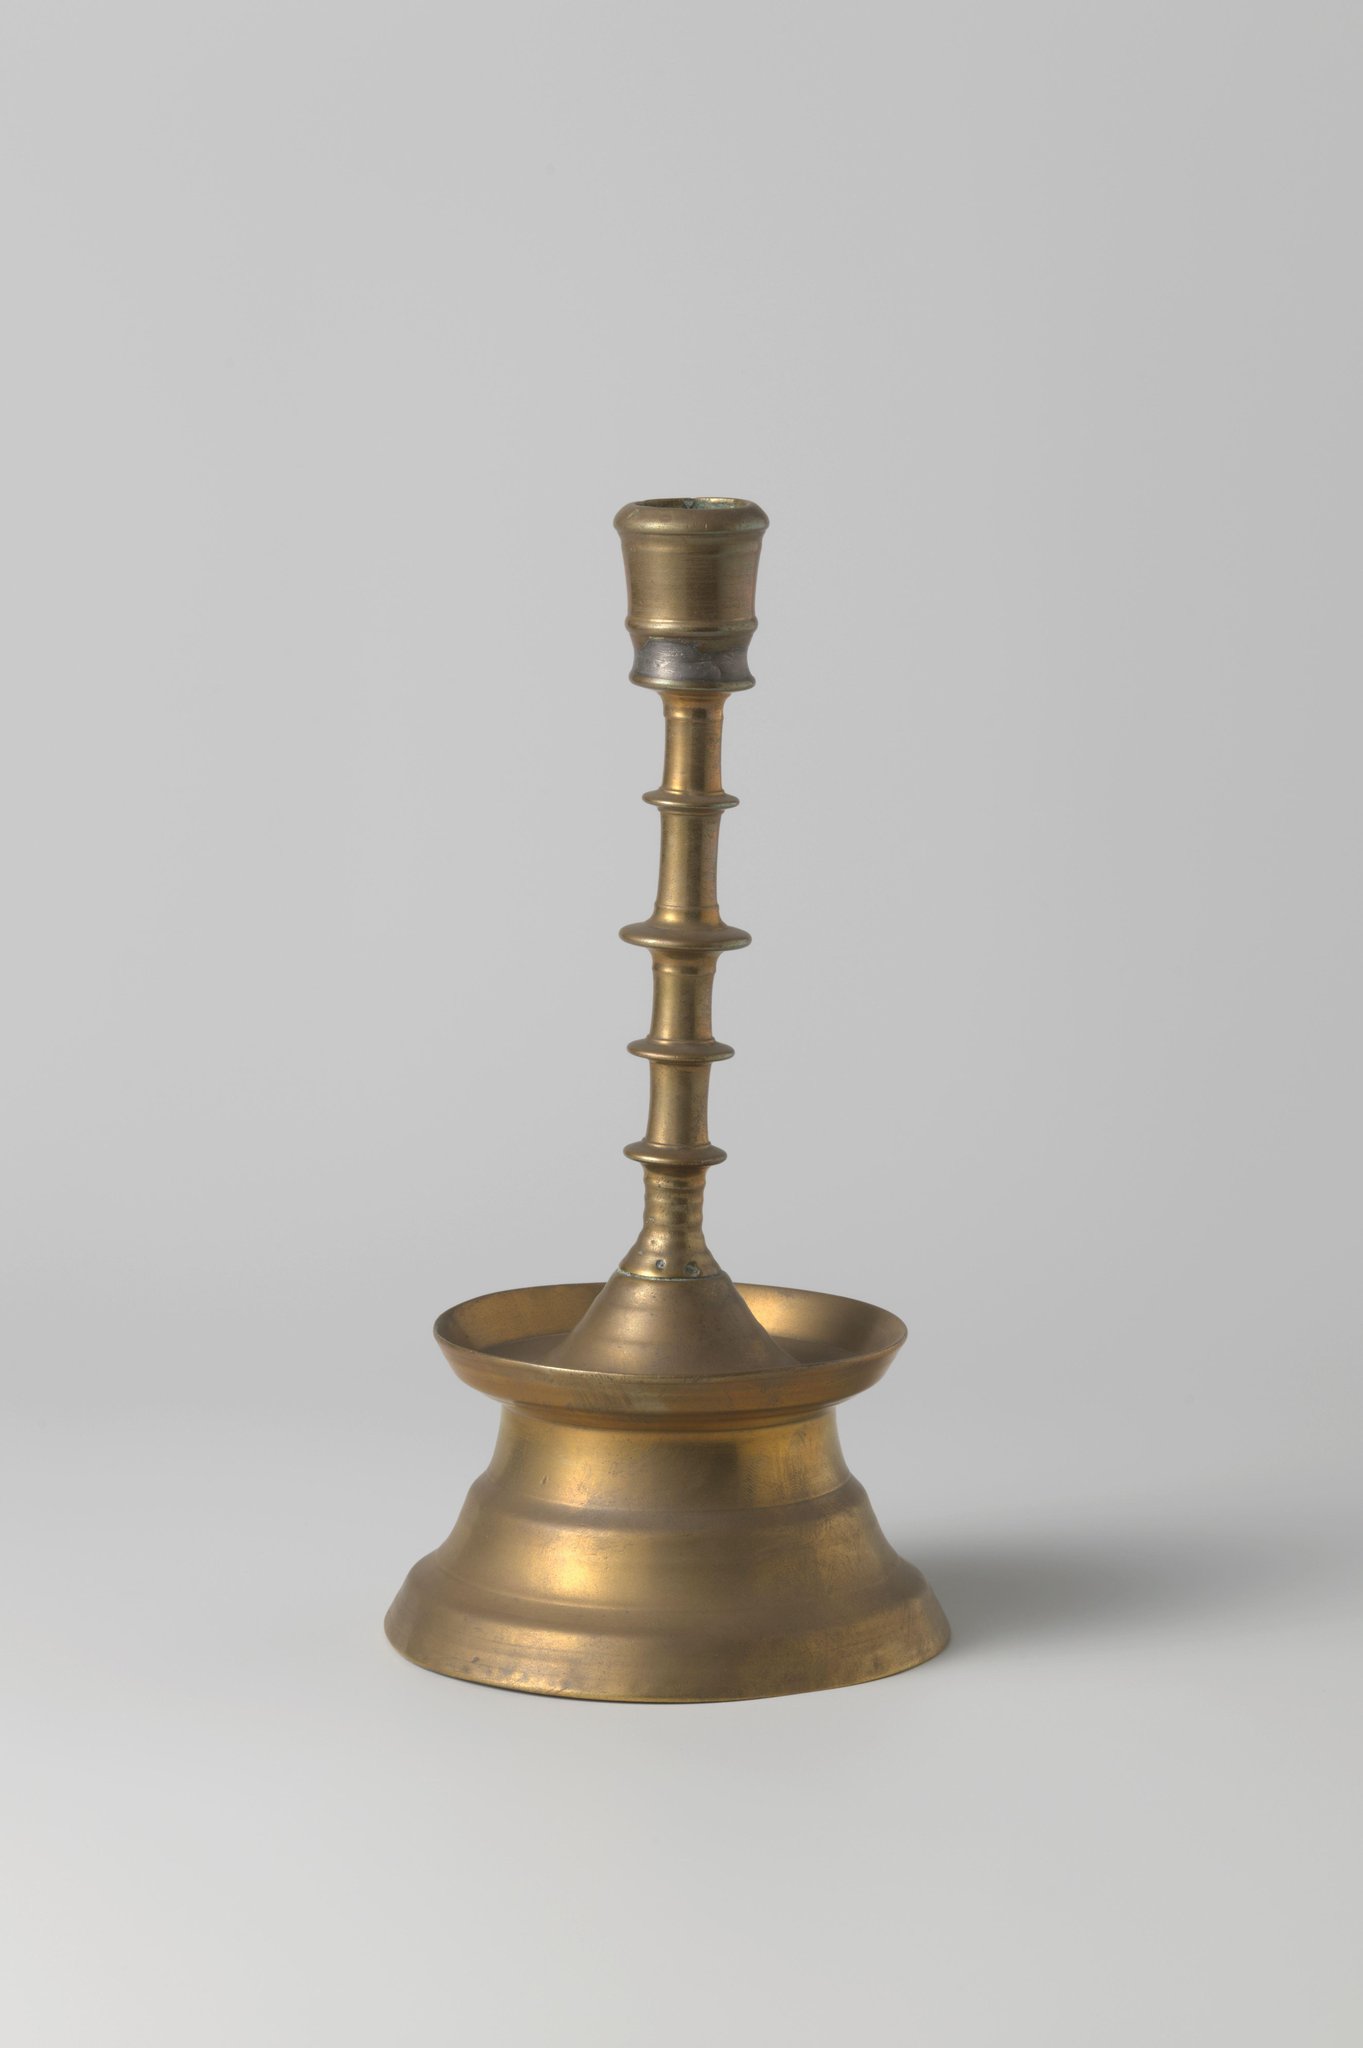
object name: candlestick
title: Kandelaar van messing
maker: Anonymous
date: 1450-1500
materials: brass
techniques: casting, riveted, soldering, turning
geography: northern netherlands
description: Het voorwerp is samengesteld uit twee delen: de voet en de stam met kaarsenhouder. Zij zijn gegoten en daarna afgedraaid. De hoge, geprofileerde konische voet is bovenaan voorzien van een opstaande rand, waardoor hij tevens als vetvanger dienst kan doen. Op het kegelvormige middendeel is de stam geklonken en vervolgensen aan de onderkant afgedraaid. De stam, die met vier knopen is versierd en waarvan één iets groeter is, gaat bovenaan over in een geprofileerde nagenoeg cylindervormige houder. Voet en stam zijn met rillen versierd. De houder is bij een herstelling ingekort, waardoor de rechthoekige openingen ontbreken. De stam is aan de onderkant gesoldeerd.